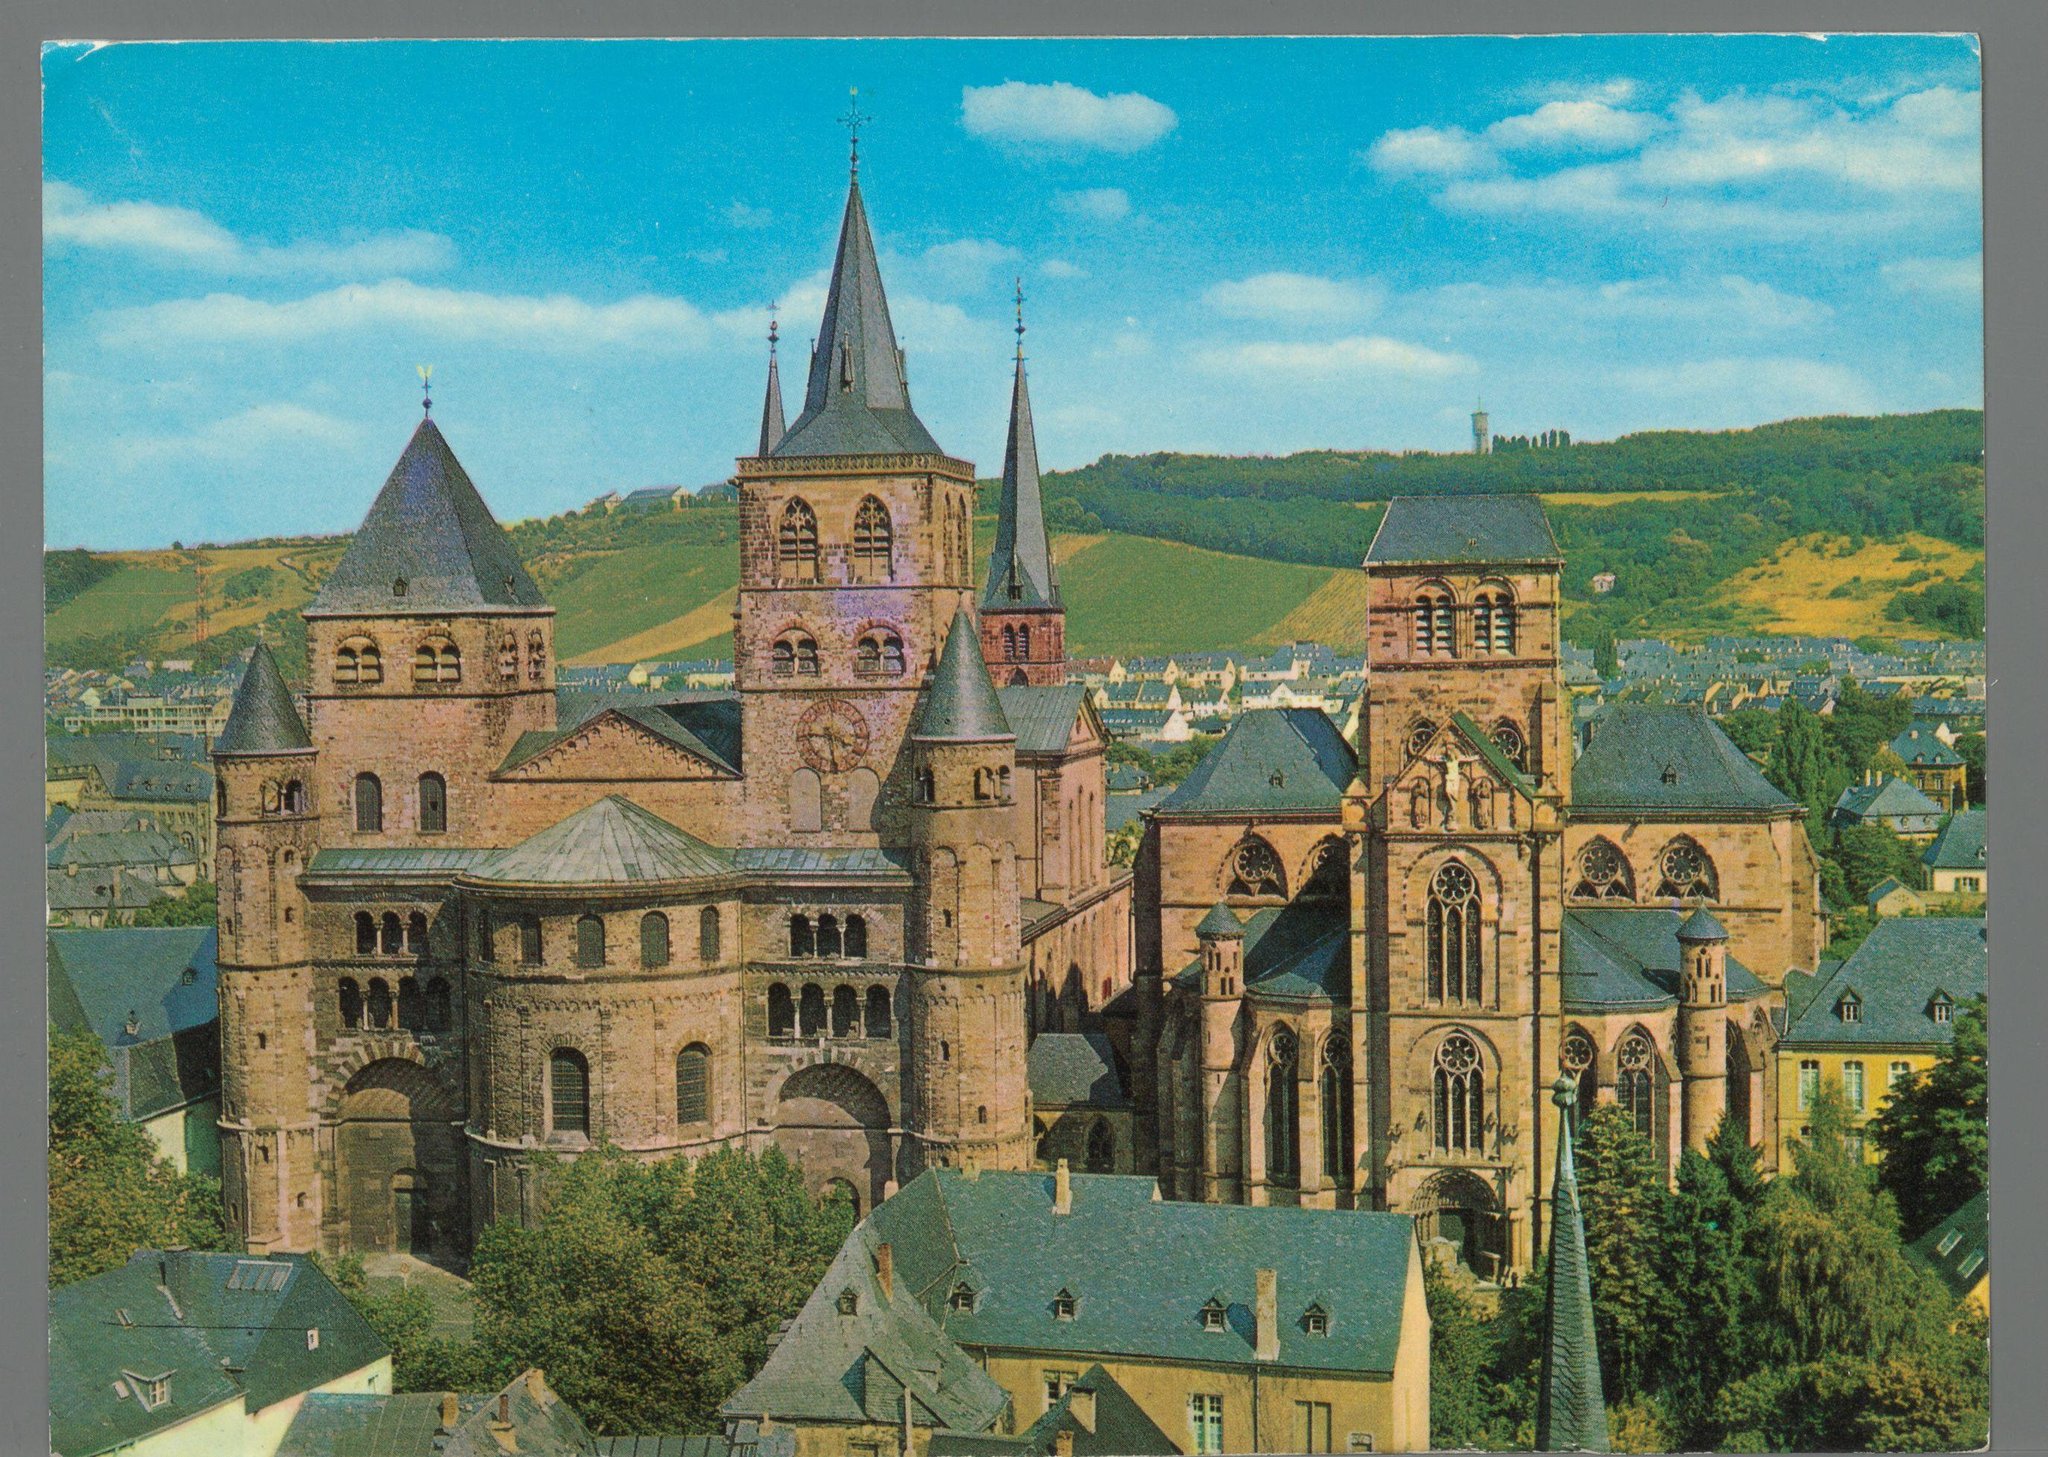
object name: photomechanical print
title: Trier - älteste Stadt Deutschlands. Dom und Liebfrauenkirche / Cathedral and Church of Our Lady / Cathédrale et Notre-Dame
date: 1960-1974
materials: cardboard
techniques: offset printed, writing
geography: trier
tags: church (exterior)